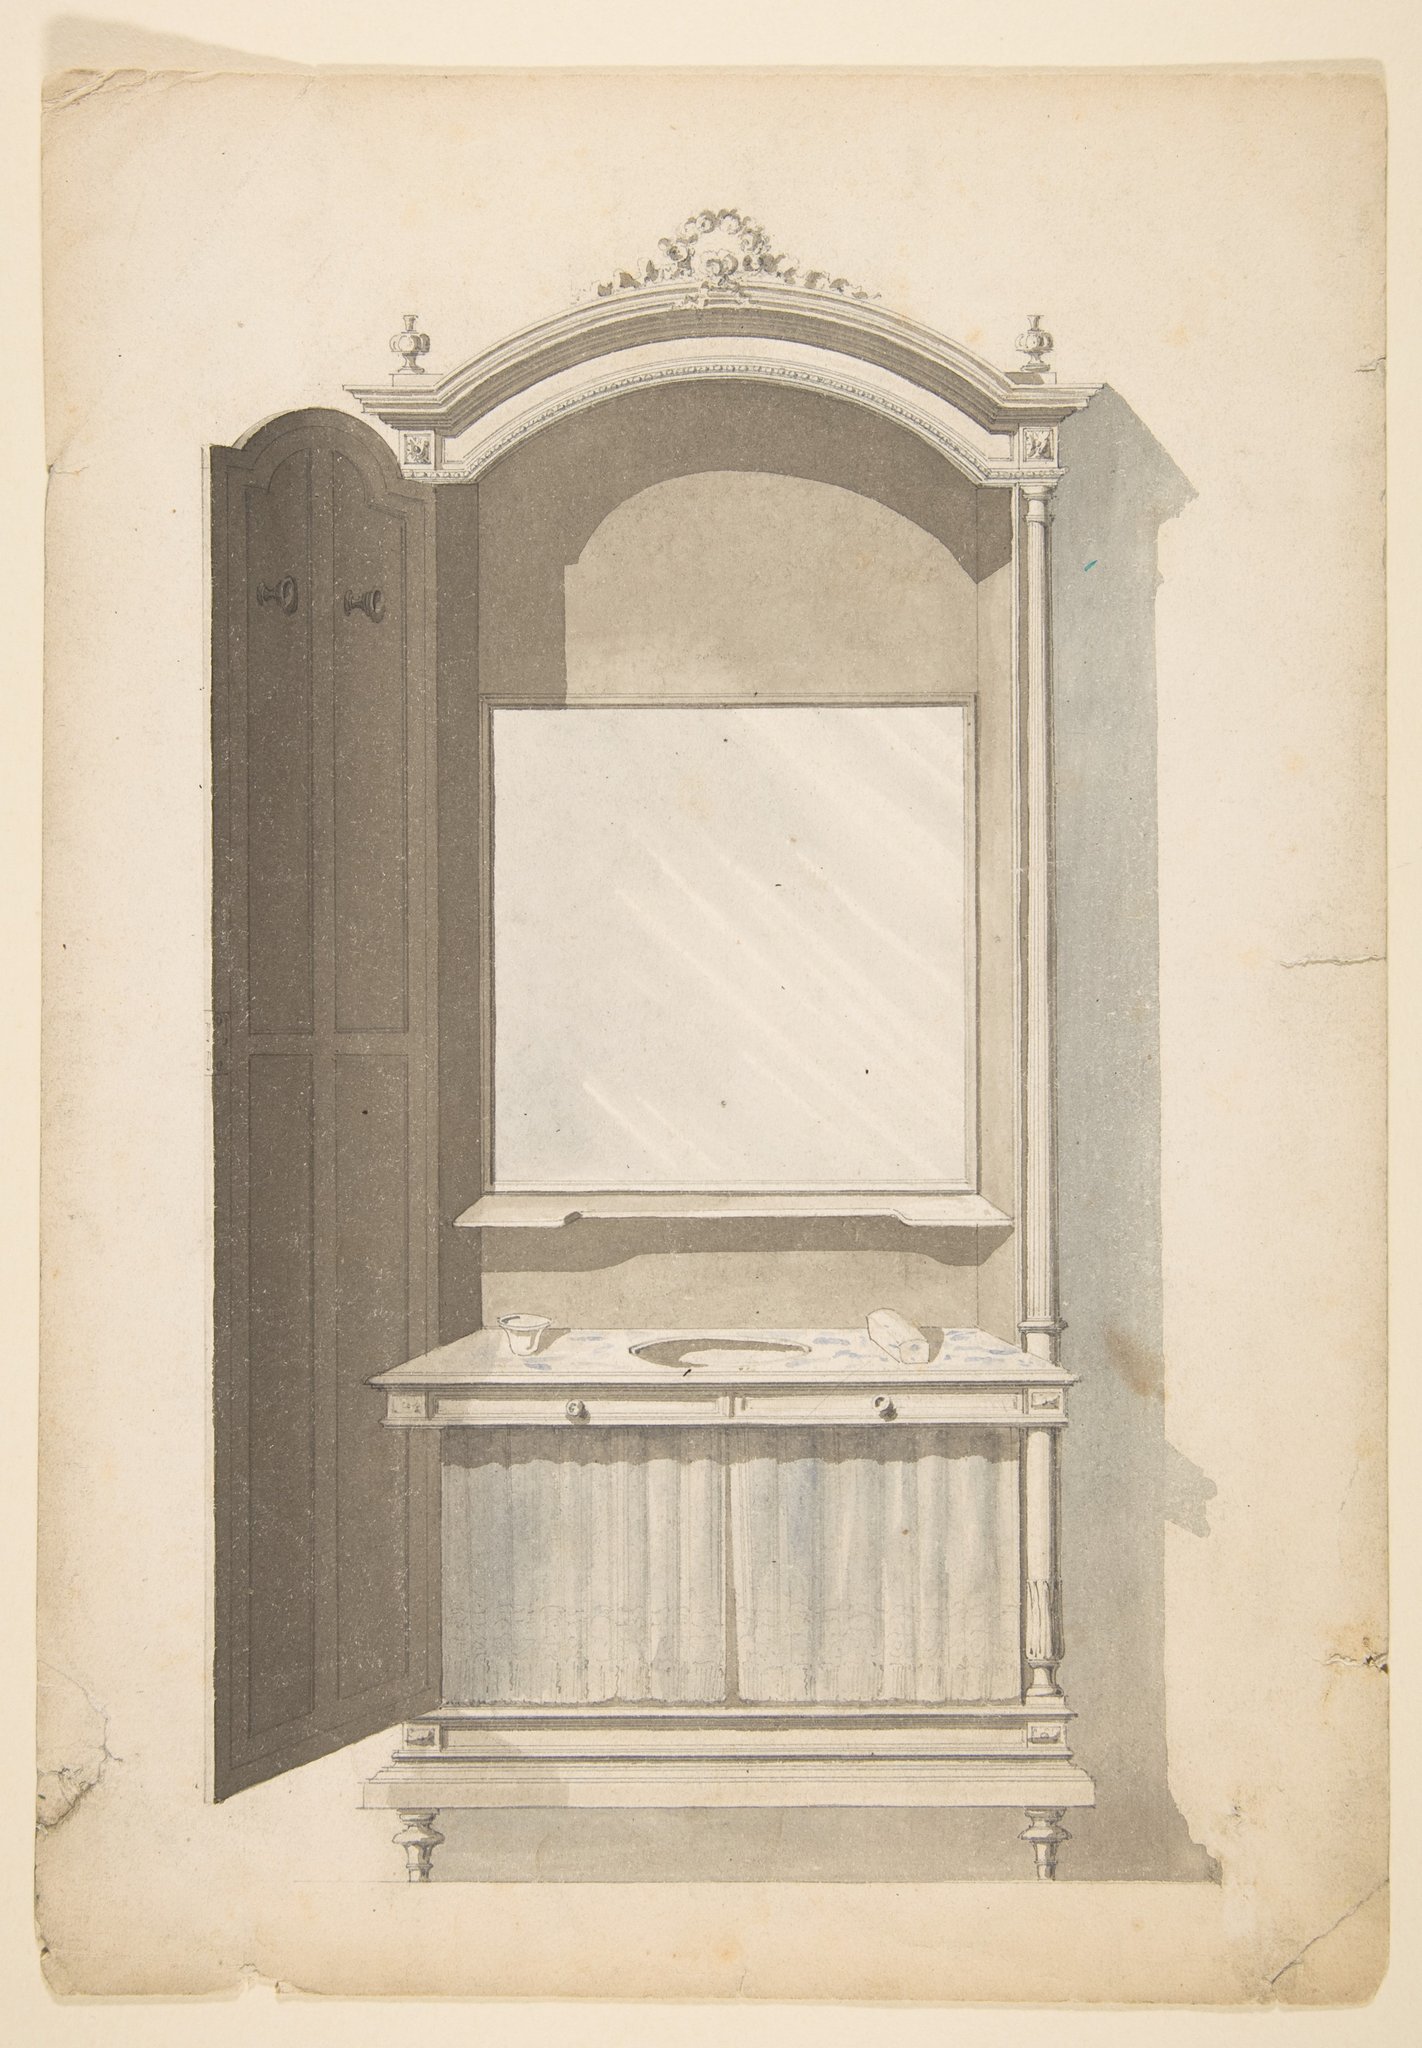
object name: drawing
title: Design for a Sink and Vanity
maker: anonymous, french, 19th century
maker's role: artist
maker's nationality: french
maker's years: 1800-1900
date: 1801-1900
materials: ink, watercolor, paper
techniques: pen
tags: furniture,mirrors